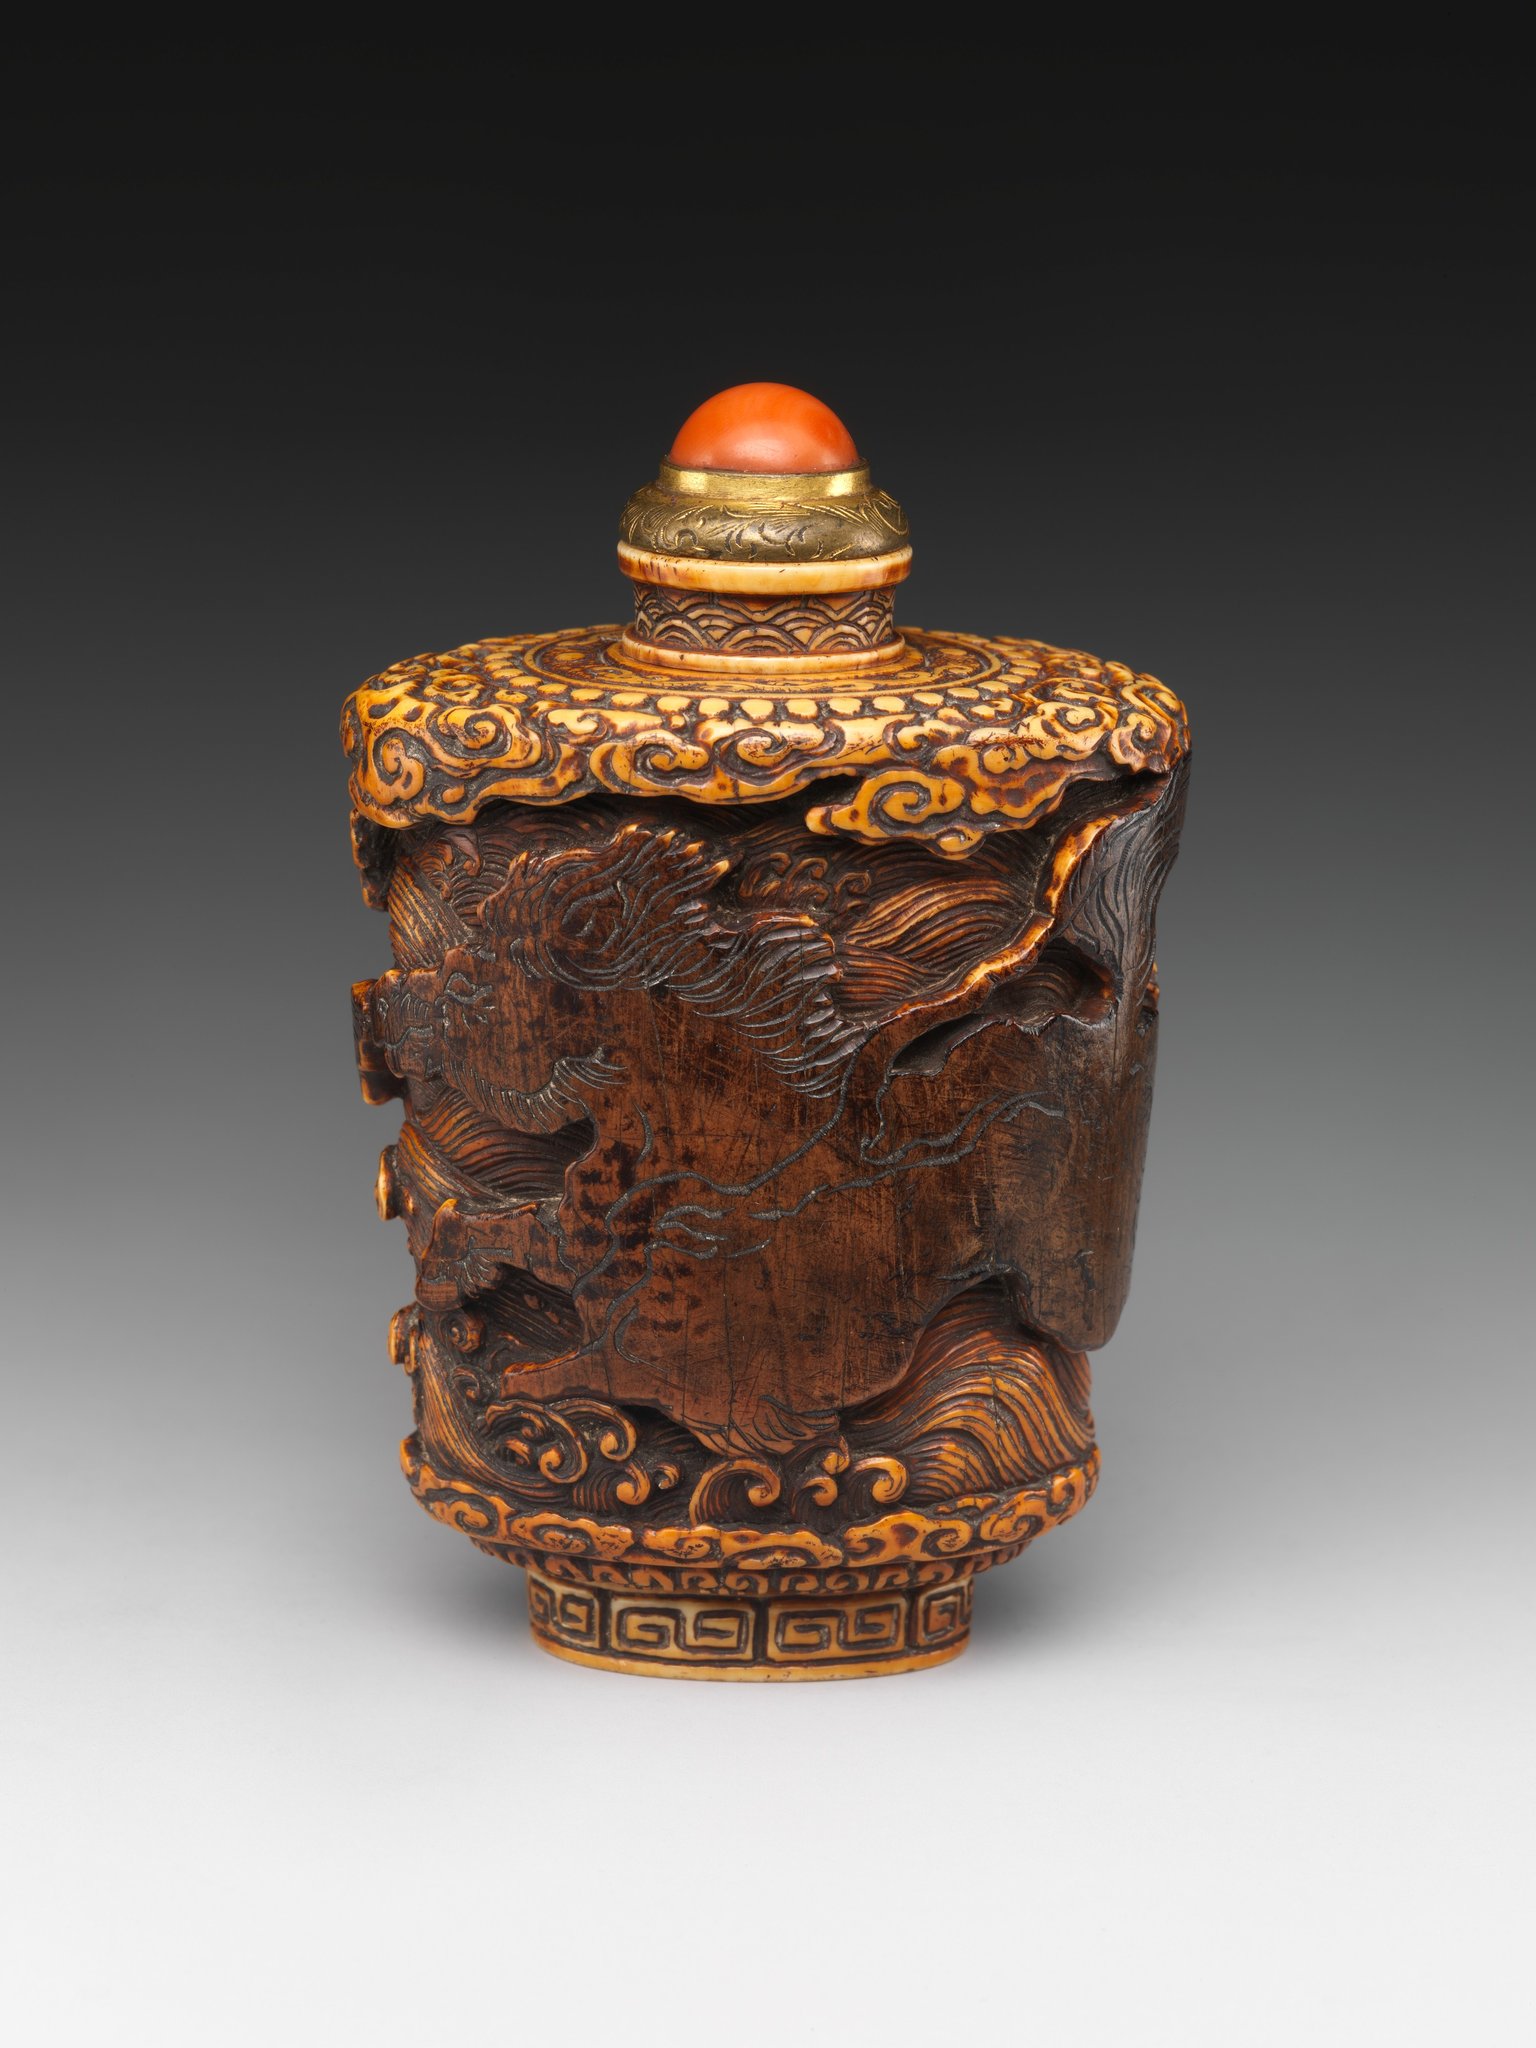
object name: snuff bottle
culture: chinese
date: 1736-1795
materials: alloy, coral, gilt copper, ivory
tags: horses